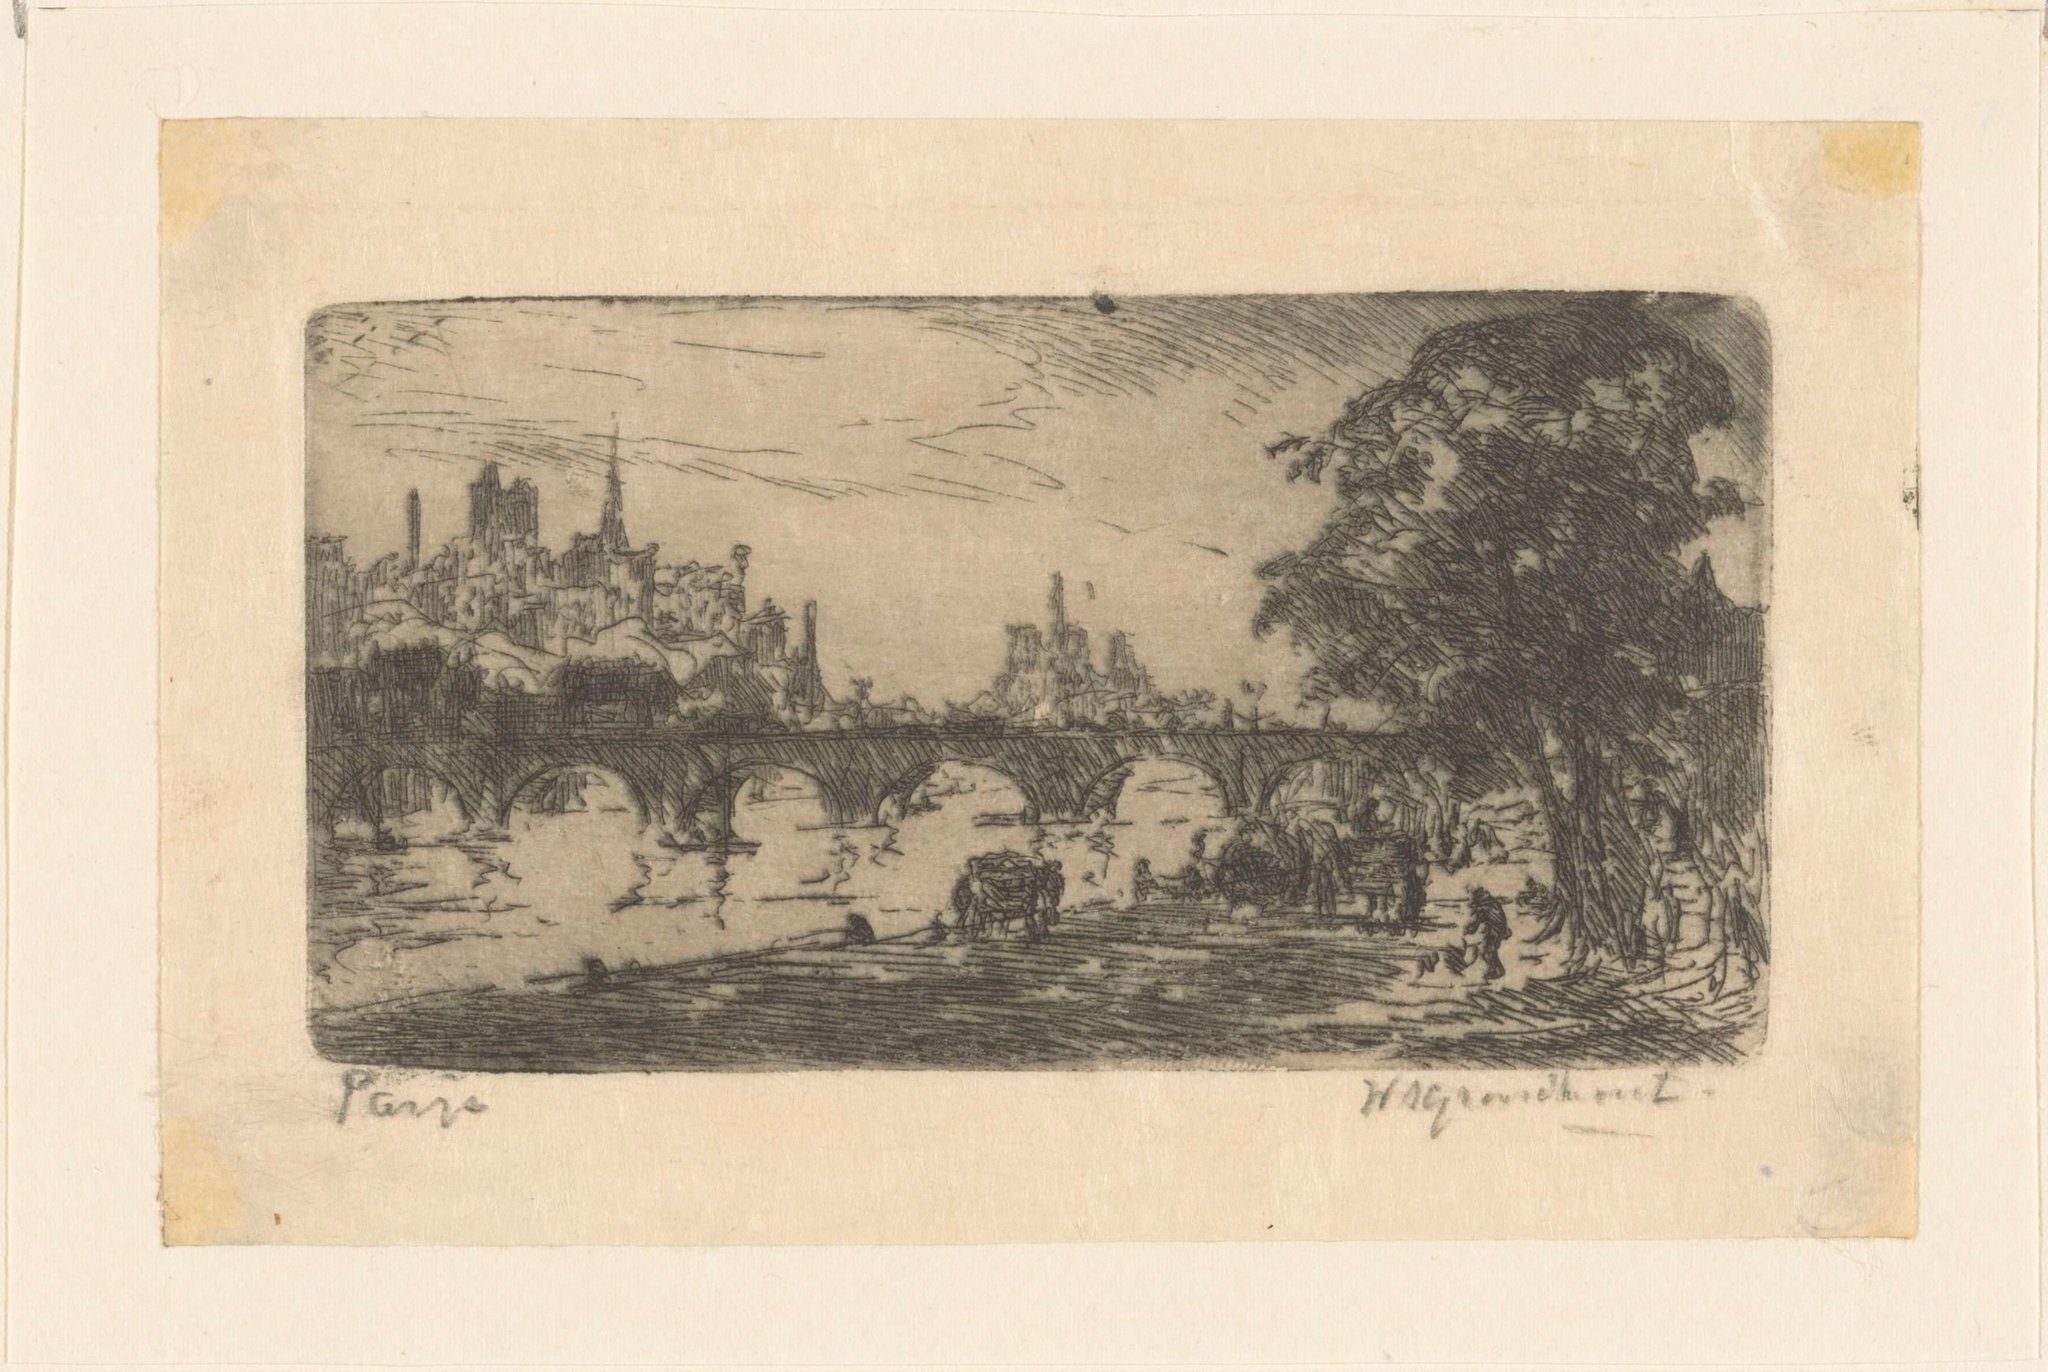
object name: print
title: Parijs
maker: willem adrianus grondhout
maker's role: draughtsman, painter, print maker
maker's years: 1878-1934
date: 1888-1934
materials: paper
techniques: etching, intaglio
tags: bridge in city across river, canal, etc., paris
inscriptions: collector's mark: Lugt 2228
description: Een brug over de Seine in Parijs. Op de achtergrond bebouwing.